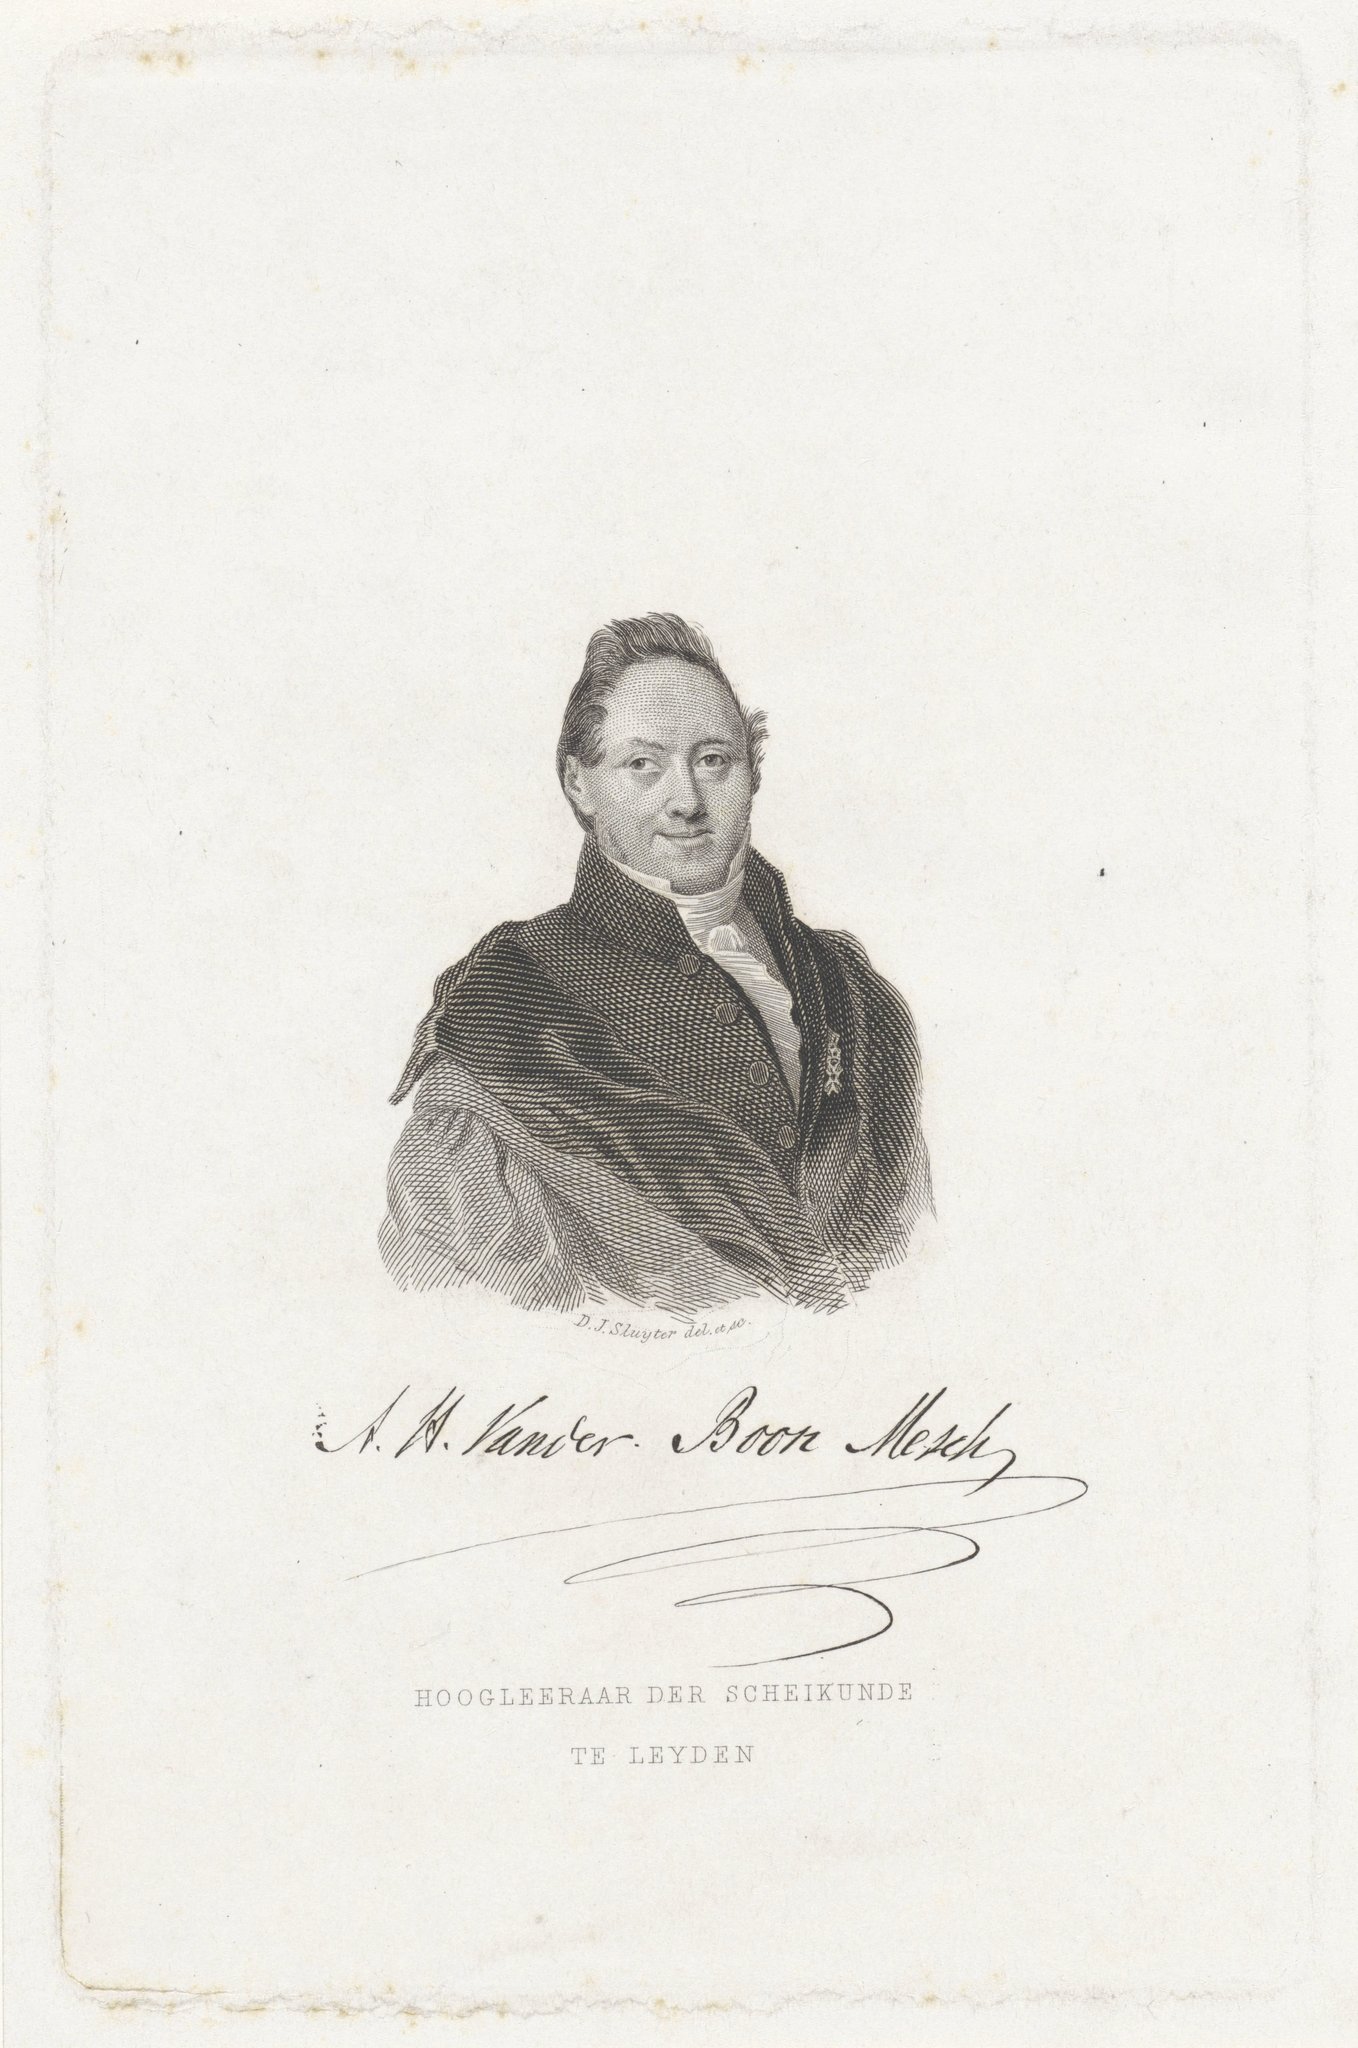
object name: print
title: Portret van de hoogleraar Anthony Hendrik van der Boon Mesch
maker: dirk jurriaan sluyter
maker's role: draughtsman, print maker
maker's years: 1811-1886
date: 1829-1886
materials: paper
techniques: etching, engraving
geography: amsterdam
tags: hoogleraar, anthony hendrik van der boon mesch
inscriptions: collector's mark: Lugt 2228